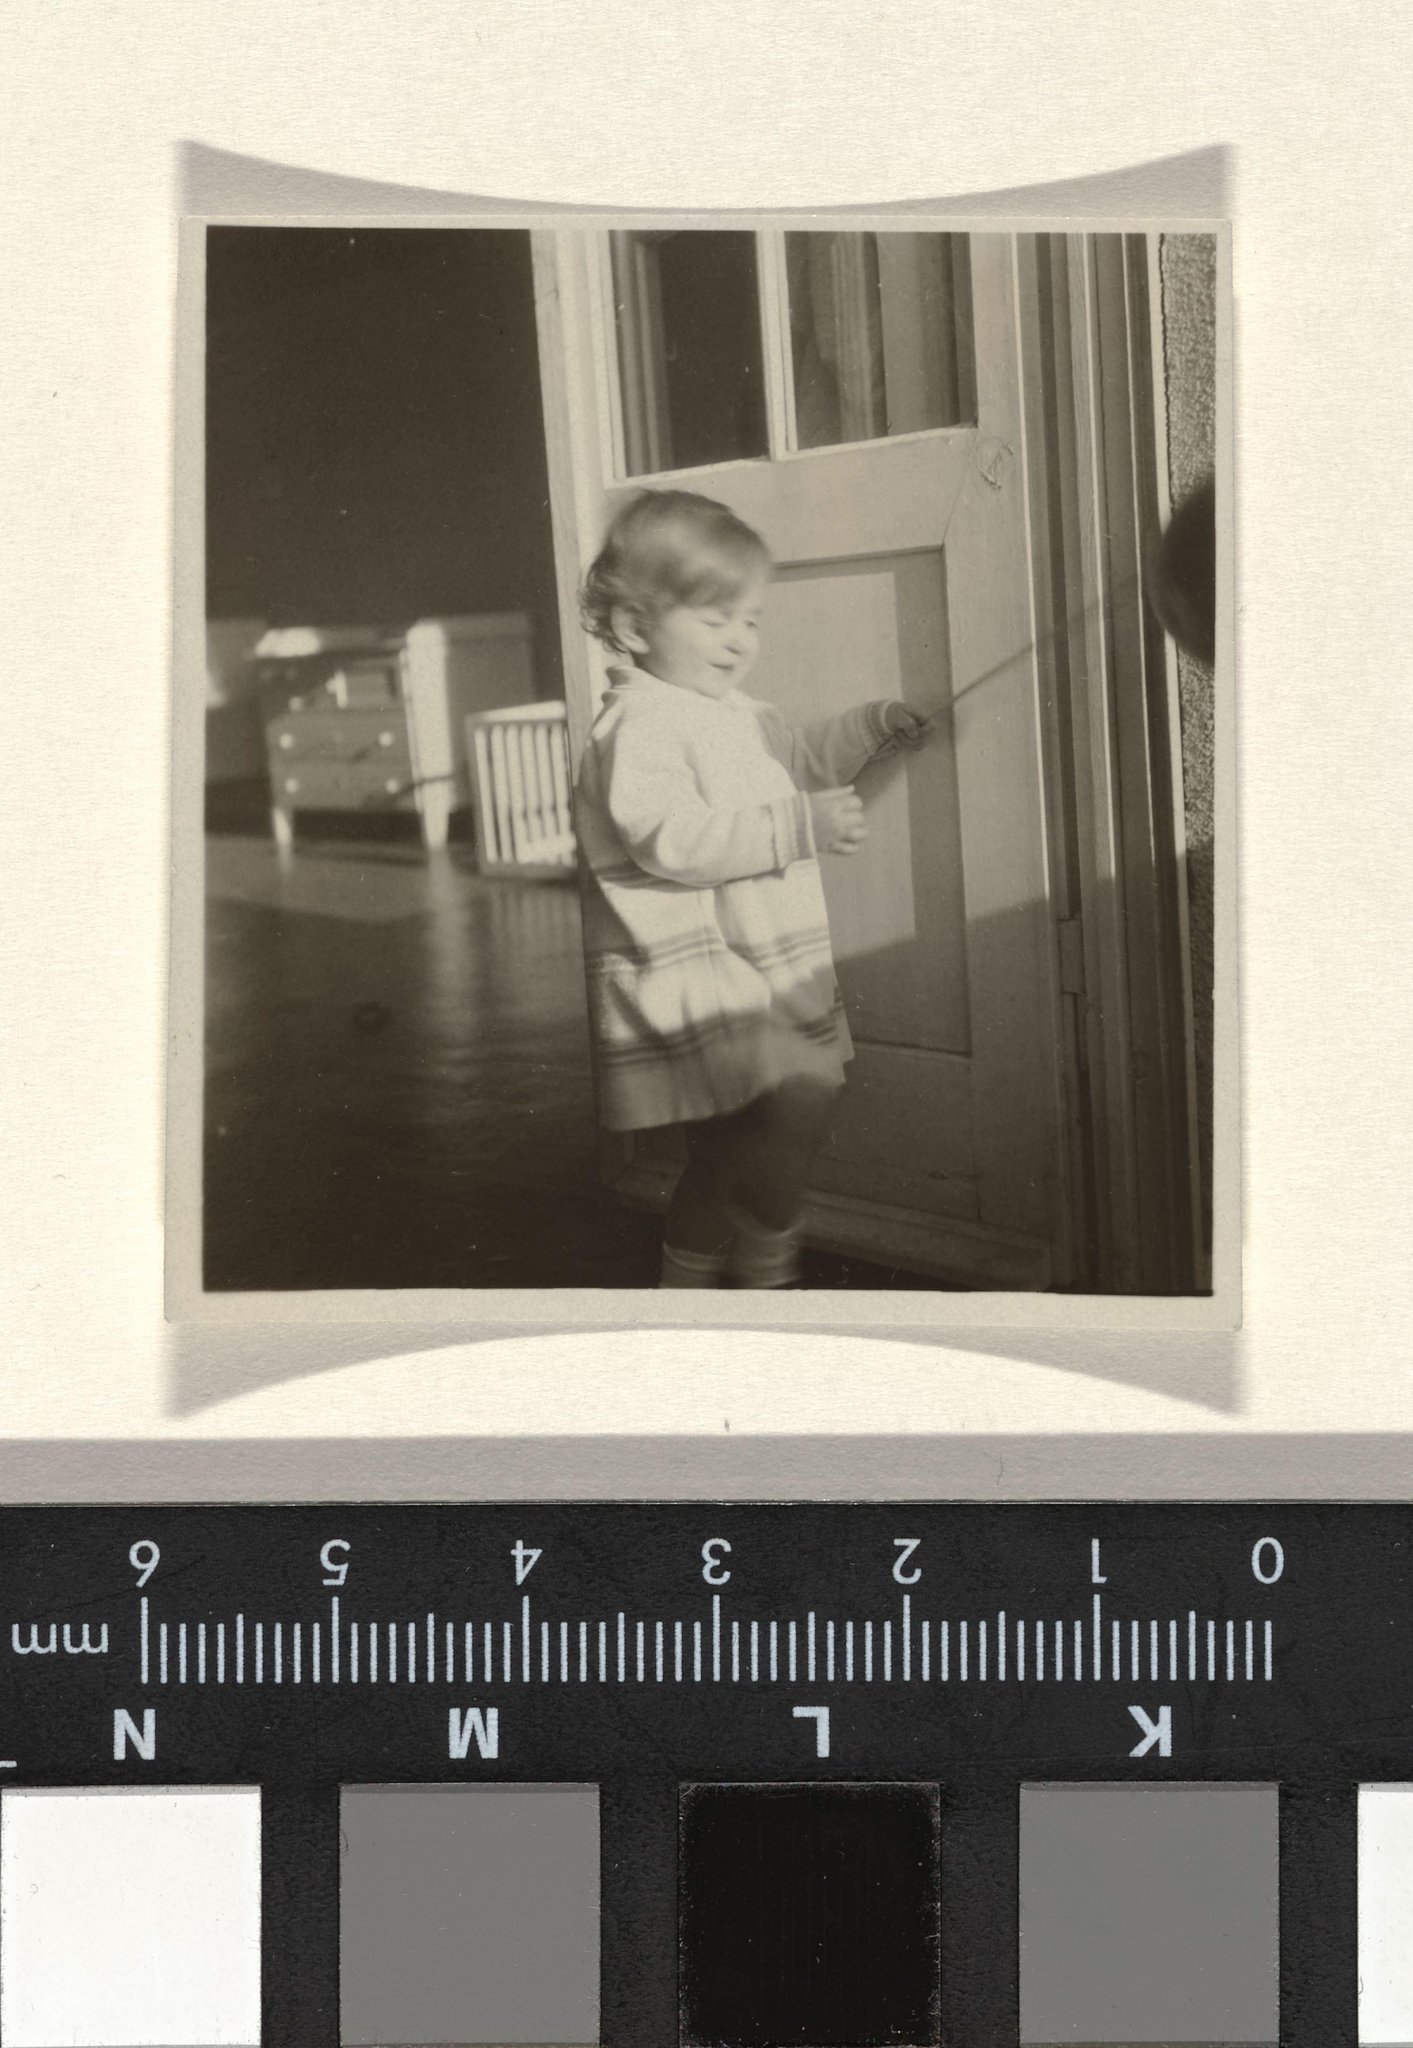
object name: photograph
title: Isabel Wachenheimer in de deuropening van een balkon, januari 1930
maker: Anonymous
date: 1901-1930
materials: photographic support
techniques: gelatin silver print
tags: leiden, isabel wachenheimer-elon, josefine moos-levi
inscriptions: number: ‘5’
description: Dit object is onderdeel van de nalatenschap van Isabel Elon-Wachenheimer (1928-2010). Tot haar overlijden behoorde het samen met de andere objecten uit de nalatenschap tot haar privédomein van Isabel Wachenheimer. In die particuliere context zijn deze objecten tezamen en individueel aandenkens - aan de jeugd, ouders en familie van Isabel Wachenheimer vóór en tijdens de Shoah en aan haar leven na de Tweede Wereldoorlog. Isabel Wachenheimer, die van juni 1943 tot mei 1945 gevangen zat in Kamp Westerbork, Theresienstadt, Auschwitz, Lenzing a/d Oberdonau (een buitenkamp van Mauthausen), overleefde de Shoah. Haar ouders – Eugène Wachenheimer en Else Wachenheimer-Moos - werden op 14 oktober 1944 in Auschwitz-Birkenau vermoord.